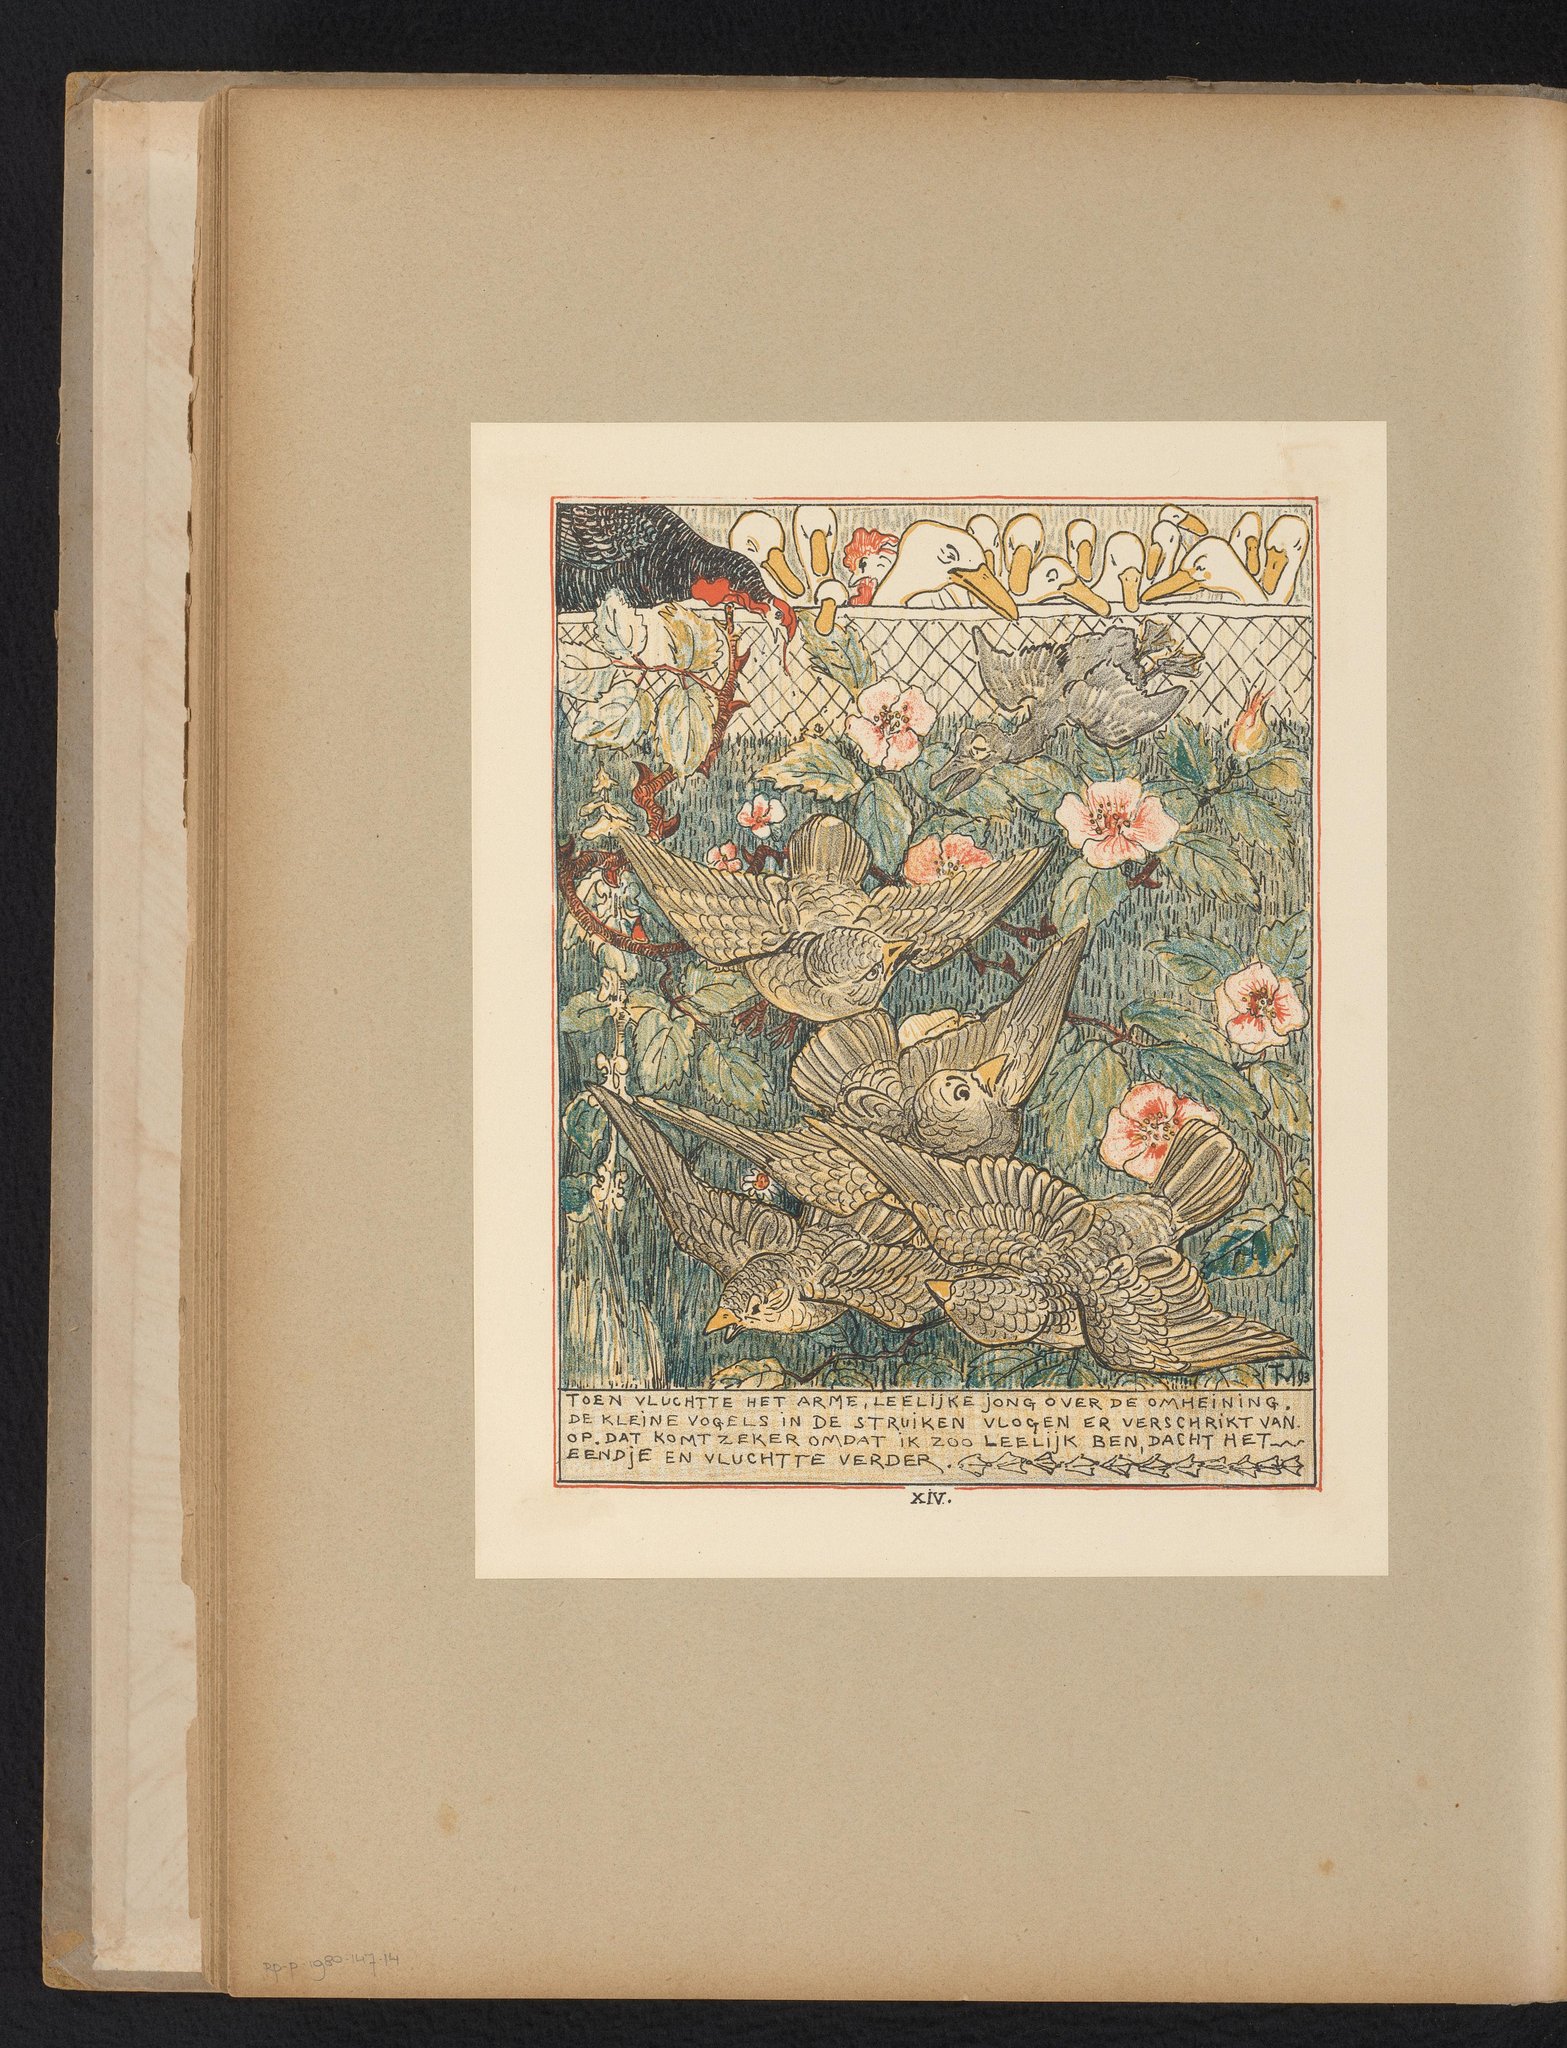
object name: album leaf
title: Zwanenjong vlucht over de omheining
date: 1893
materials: paper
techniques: lithograph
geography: amsterdam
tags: runaway child, song-birds, water-birds: duck, walker and runner birds: turkey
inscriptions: date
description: Deze prent maakt deel uit van een album.